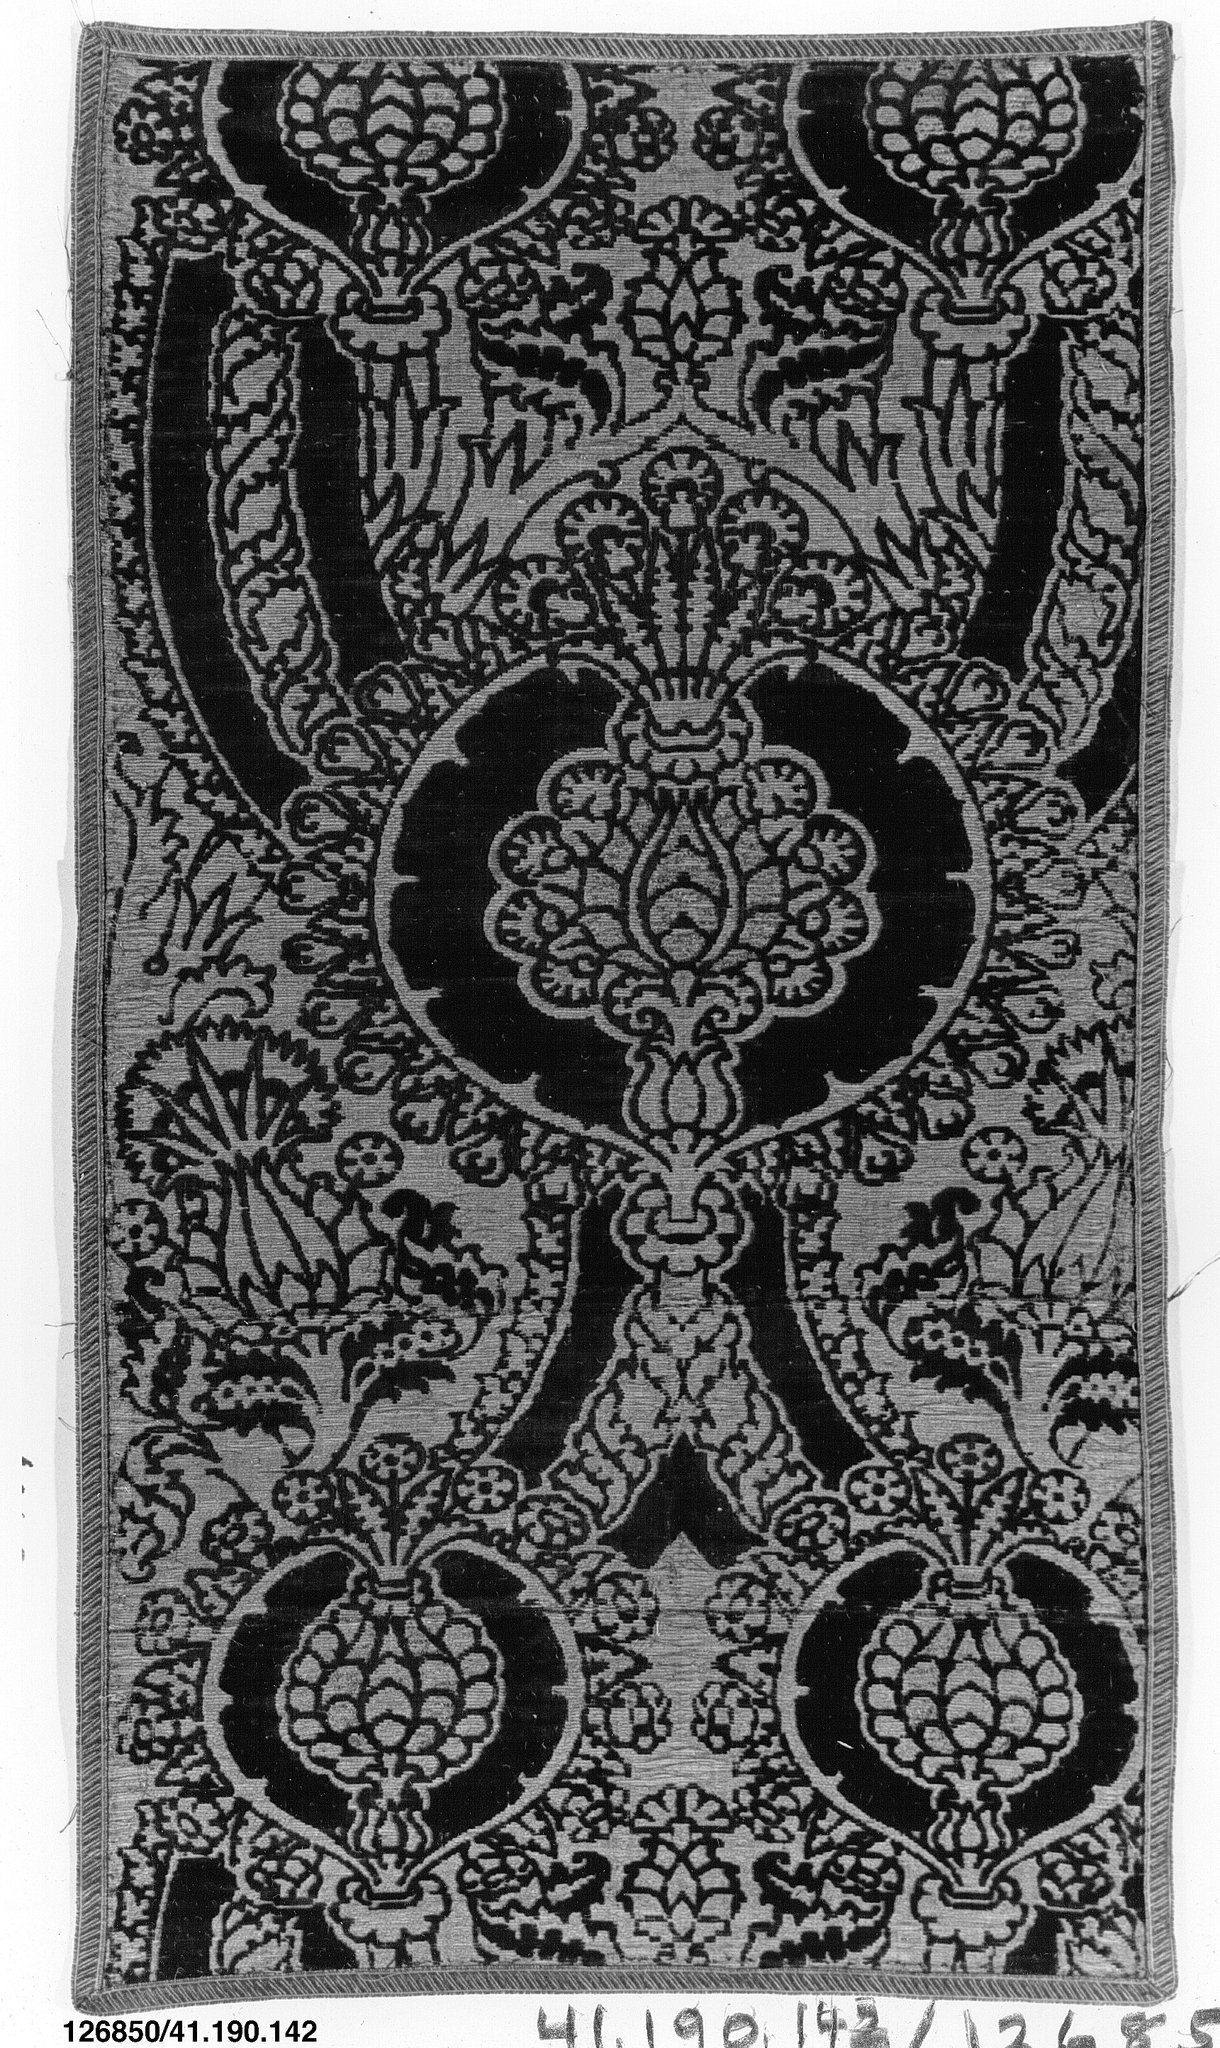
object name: panel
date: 1451-1500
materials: linen, metal thread, silk